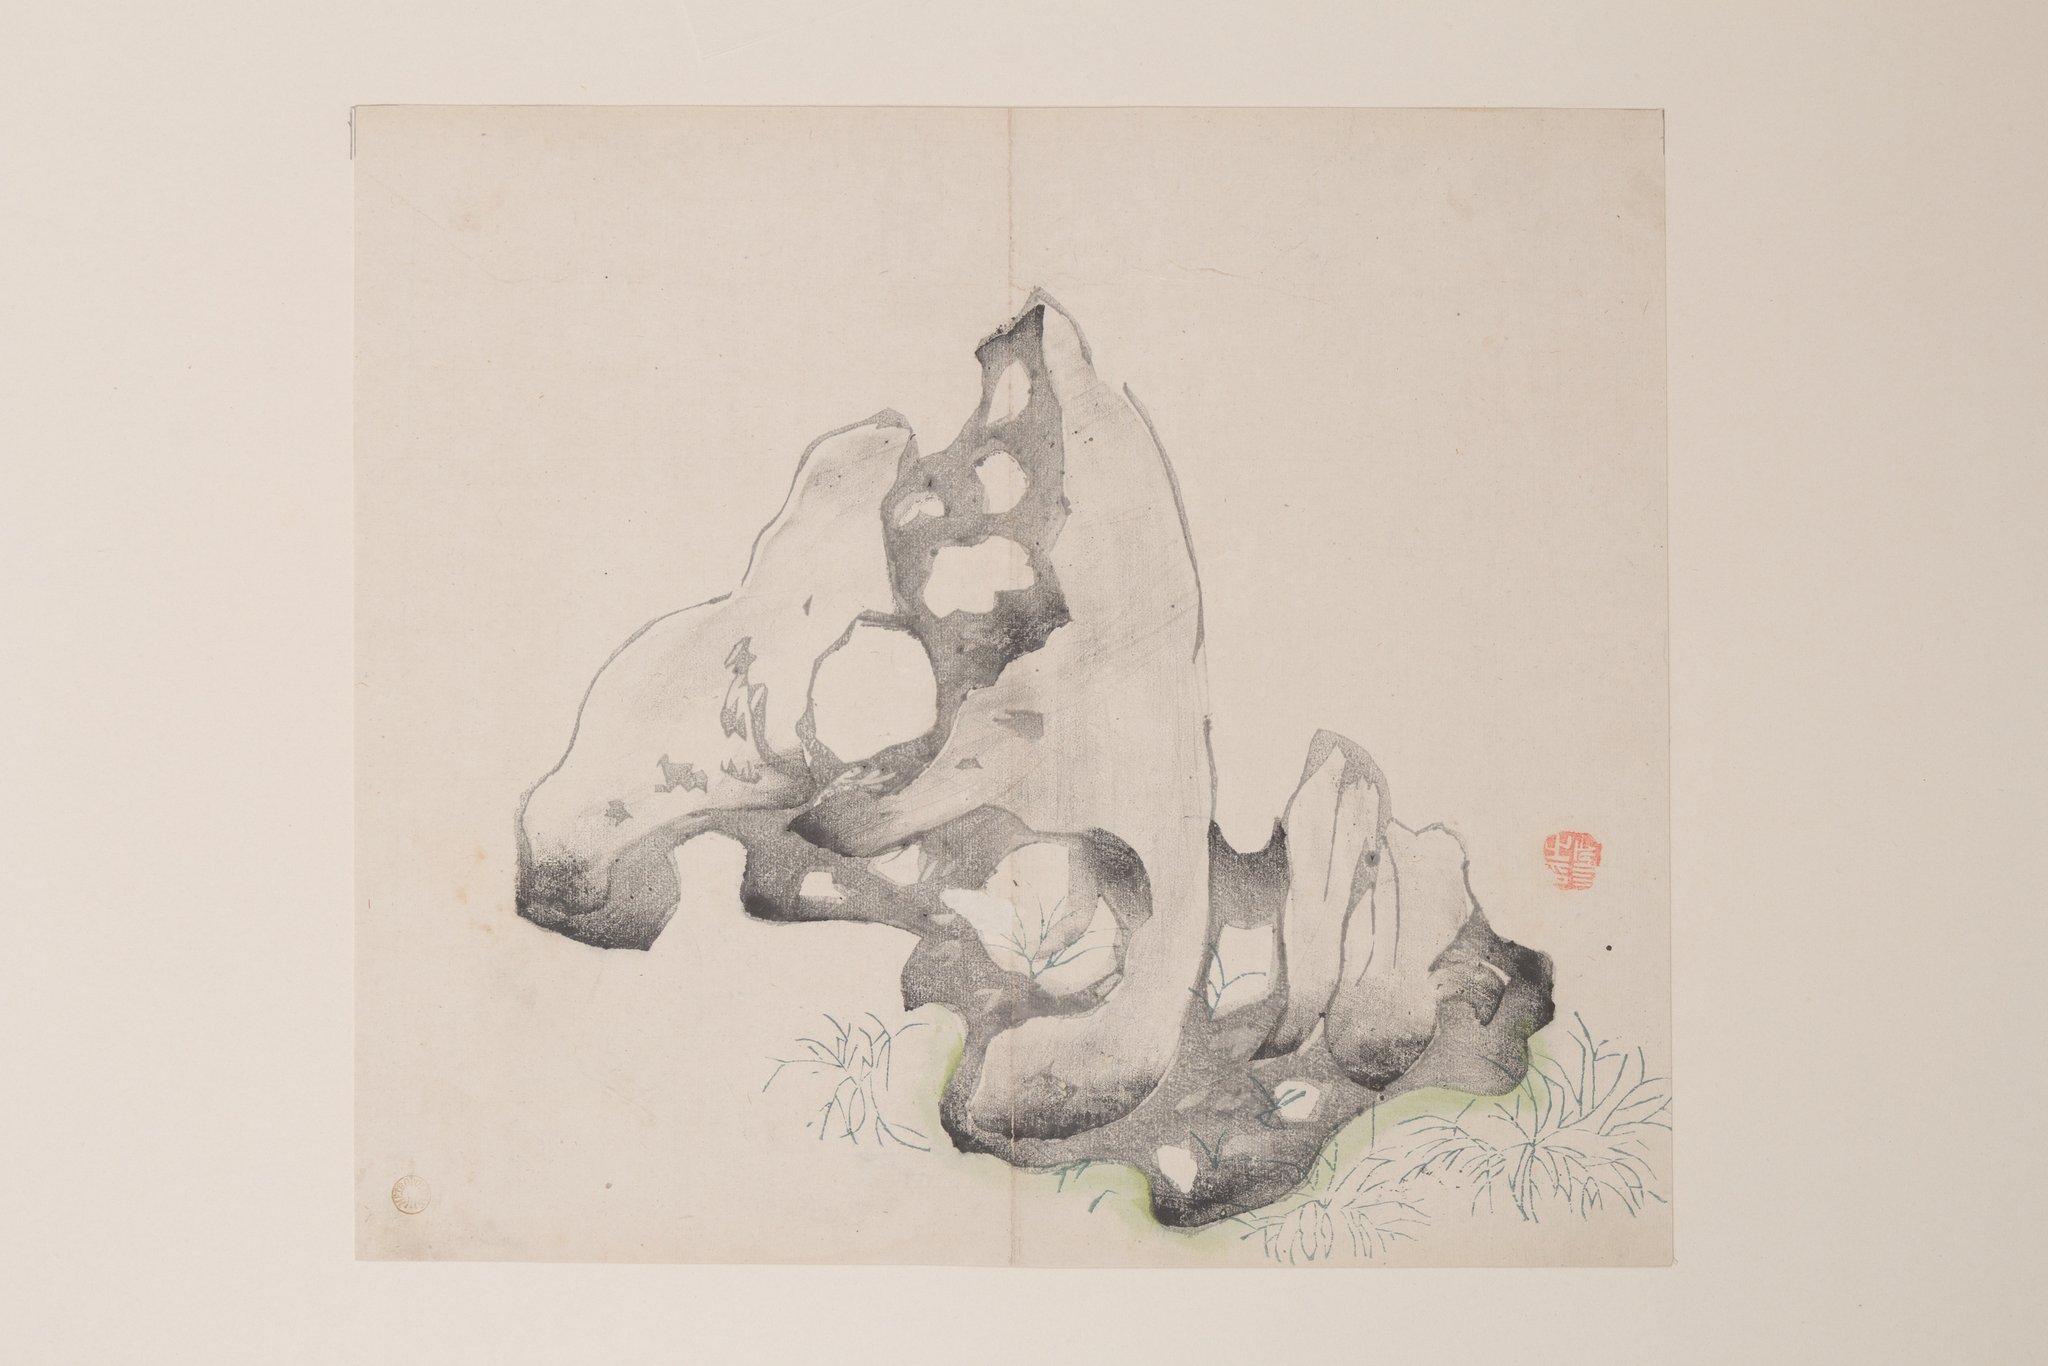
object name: print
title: Page from the Ten Bamboo Studio Manual of Painting and Calligraphy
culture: chinese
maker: hu zhengyan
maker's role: artist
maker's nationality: chinese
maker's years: 1584-1634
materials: ink, paper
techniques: printing